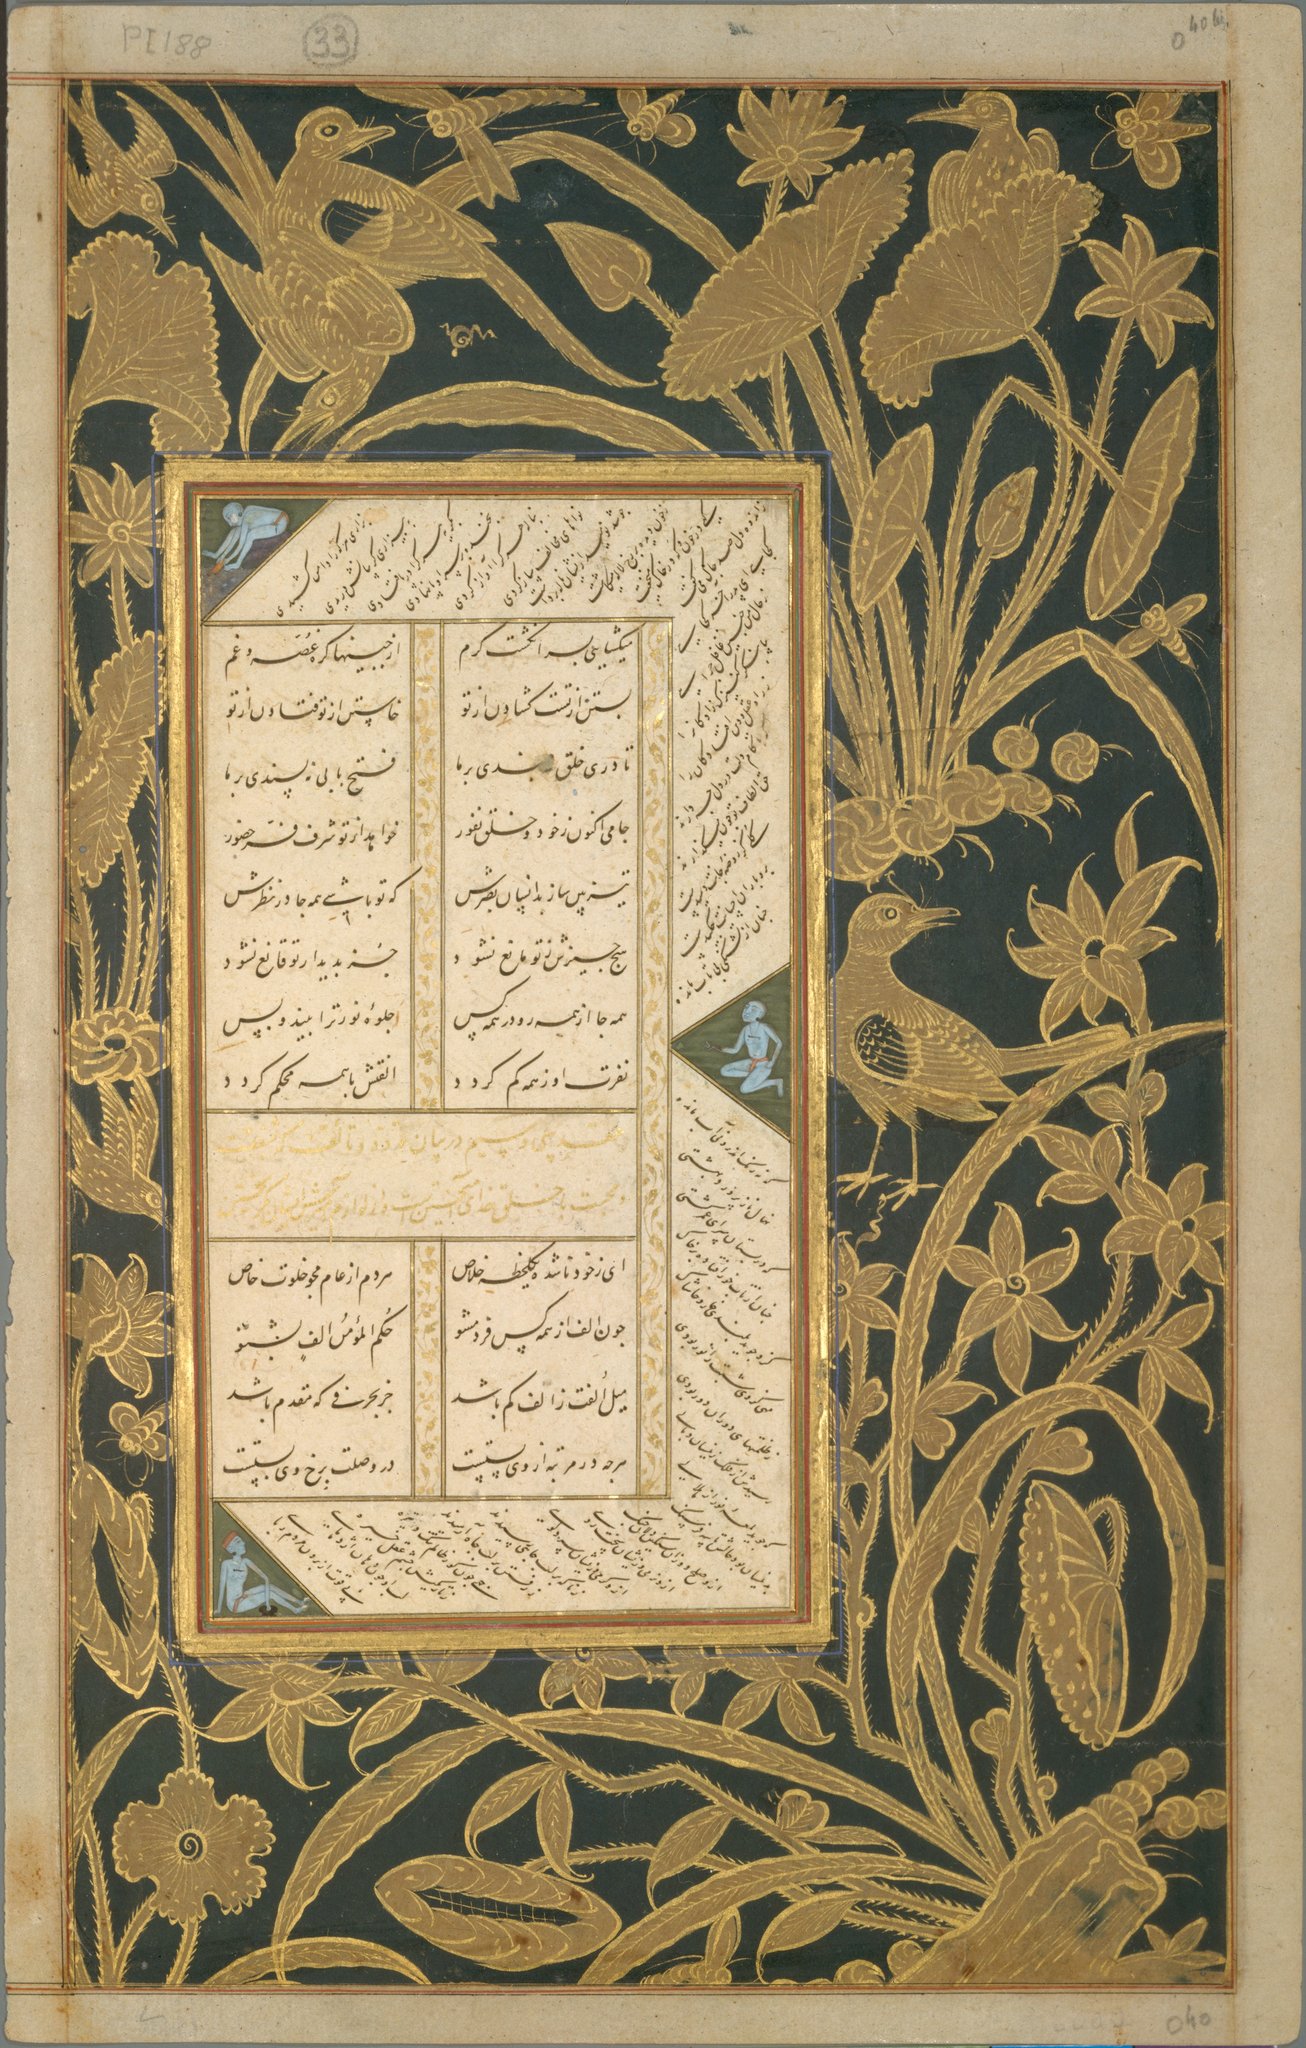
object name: folio from an illustrated manuscript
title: Page of Calligraphy with Stenciled and Painted Borders from a Subhat al-Abrar (Rosary of the Devout) of Jami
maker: maulana nur al-din `abd al-rahman jami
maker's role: author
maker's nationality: iranian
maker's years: 1414-1492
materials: gold, ink, paper, watercolor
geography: afghanistan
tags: birds,calligraphy